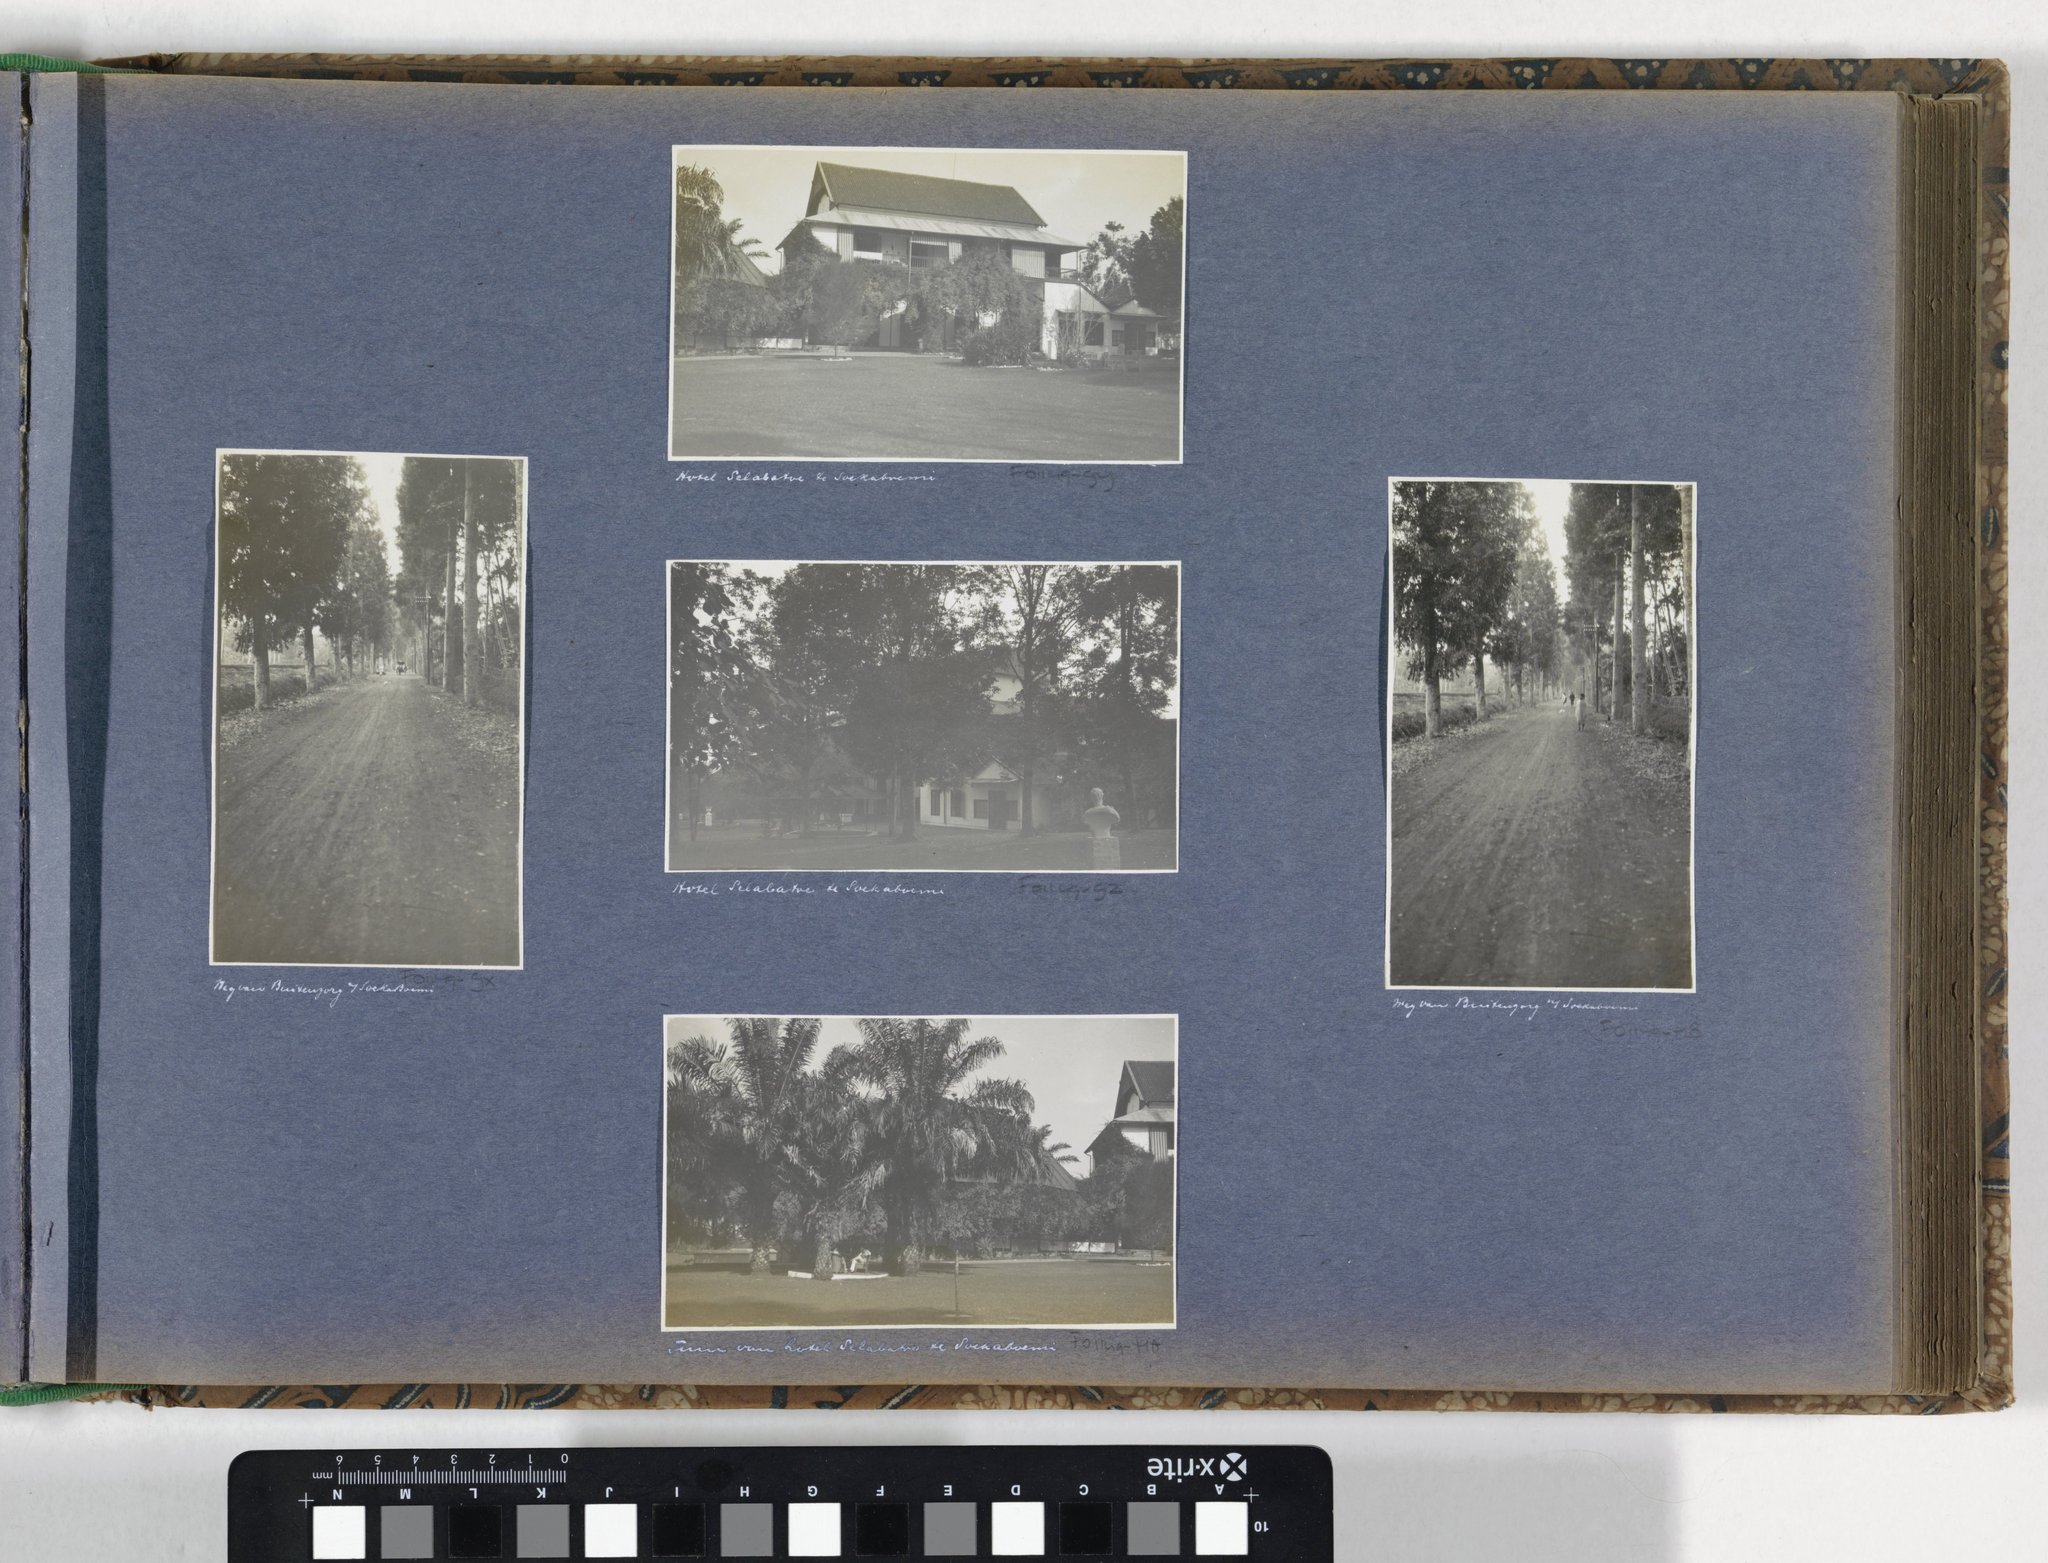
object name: album leaf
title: Exterieur van Hotel Selabatoe in Soekaboemi, door de bomen gezien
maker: Anonymous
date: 1900-1920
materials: paper, photographic support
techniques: gelatin silver print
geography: soekaboemi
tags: hotel, hostelry, inn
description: Onderdeel van reisalbum met foto's van bedrijvigheid en bezienswaardigheden op Sumatra en Java en van de reis naar en van Nederlands-Indië.